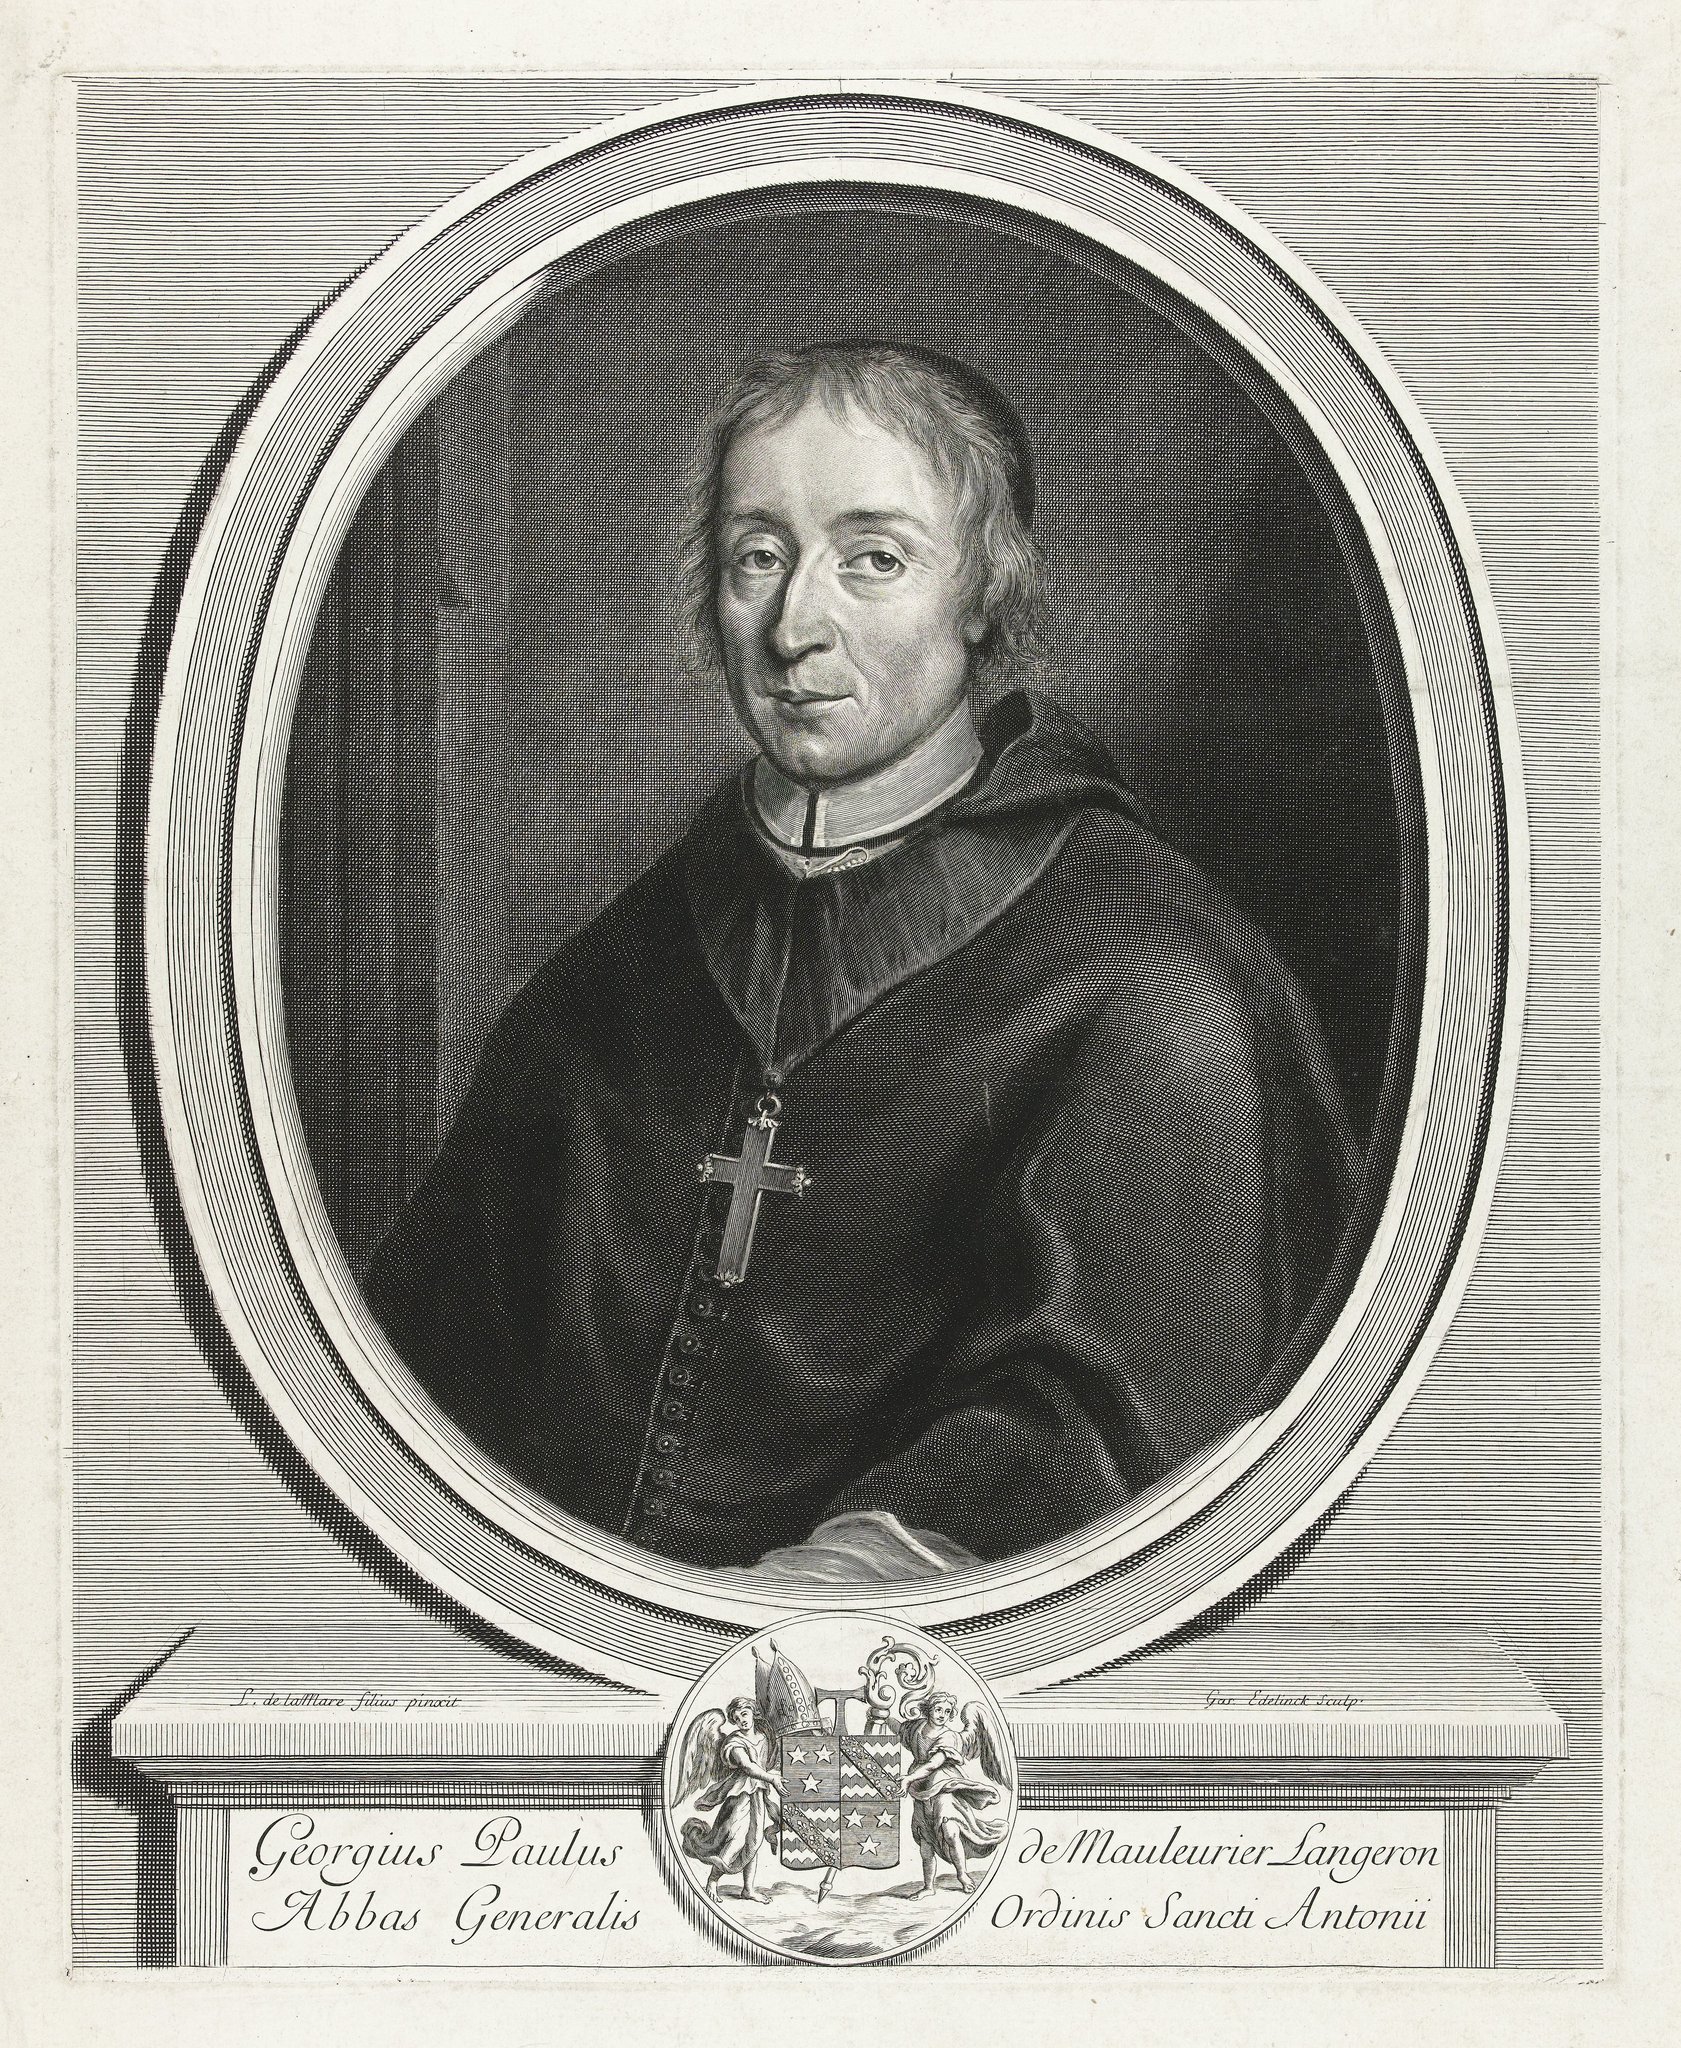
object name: print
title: Portret van Georgius Paulus de Mauleurier Langeron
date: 1654-1722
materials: paper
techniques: engraving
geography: paris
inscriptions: collector's mark: Lugt 240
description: Portret van Georgius Paulus de Mauleurier Langeron, afgebeeld in ovale omlijsting, op console met wapen en aan weerszijden twee regels Latijnse tekst.